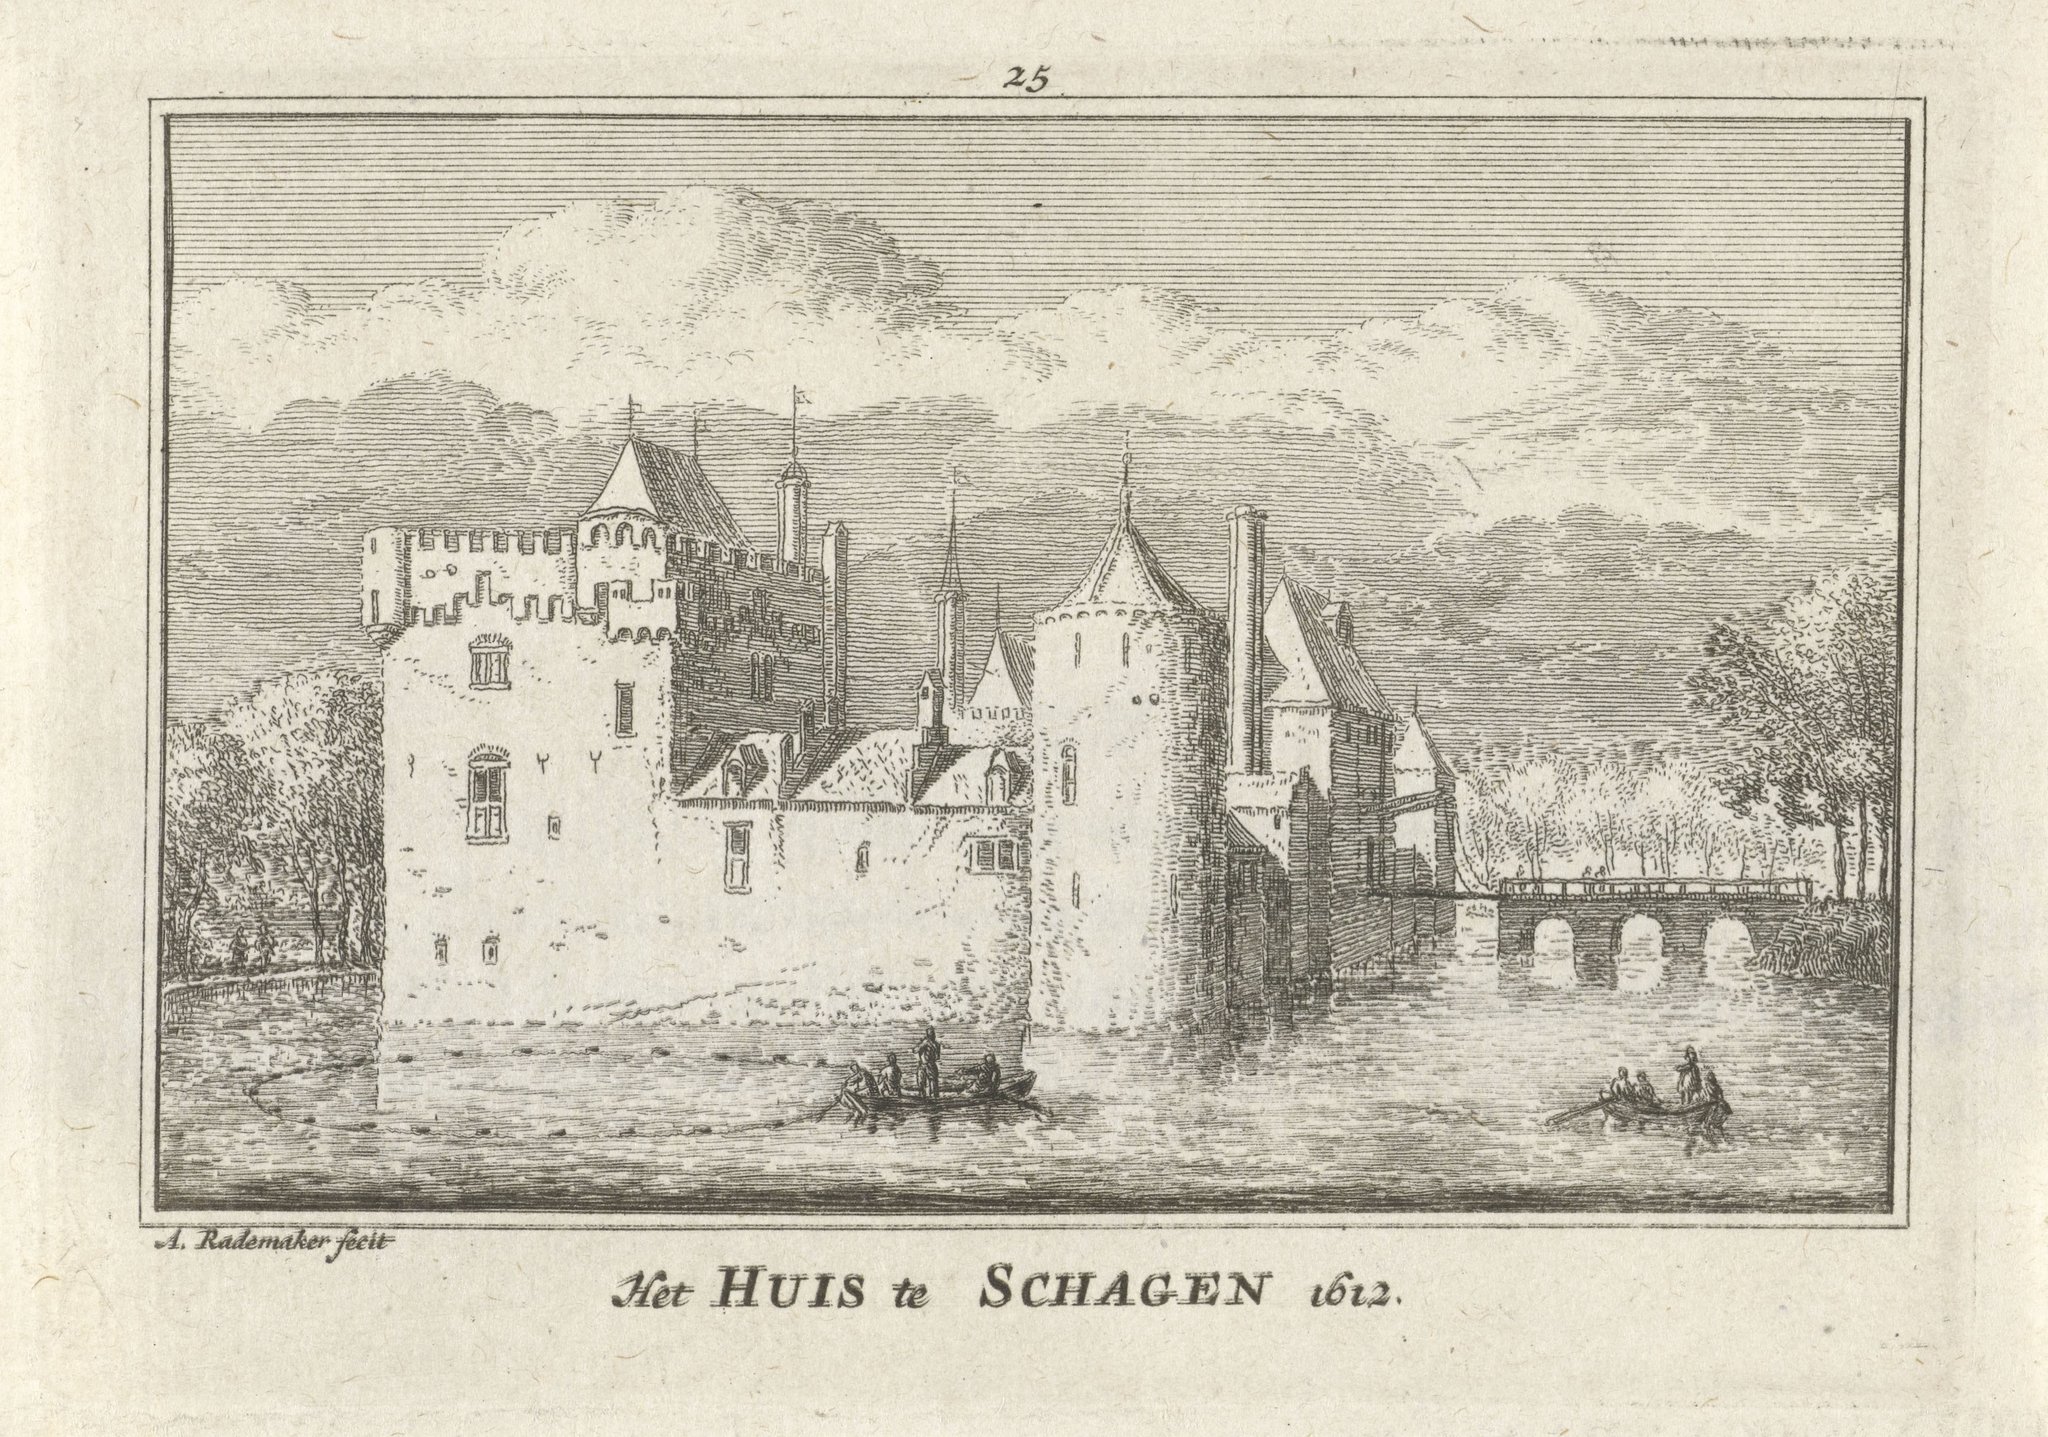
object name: book illustration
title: Gezicht op Huis te Schagen, 1612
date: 1727-1733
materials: paper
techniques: etching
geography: amsterdam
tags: castle, rowing-boat, canoe, etc., fisherman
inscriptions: collector's mark: Lugt 2228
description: Illustratie uit: Abraham Rademaker, Matthaeus Brouërius van Niedek, Isaac Le Long, Kabinet van Nederlandsche en Kleefsche outheden en (...) voorname stads- en landgebouwen, Willem Barents en Antoni Schoonenburg: Amsterdam, 1727-1733, ill. nr. 25.